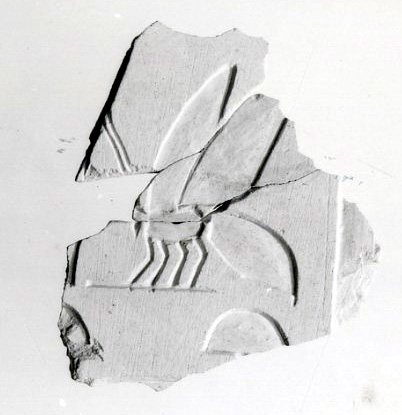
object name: relief fragment, tomb of meketre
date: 1981-1975 BCE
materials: limestone, paint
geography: egypt